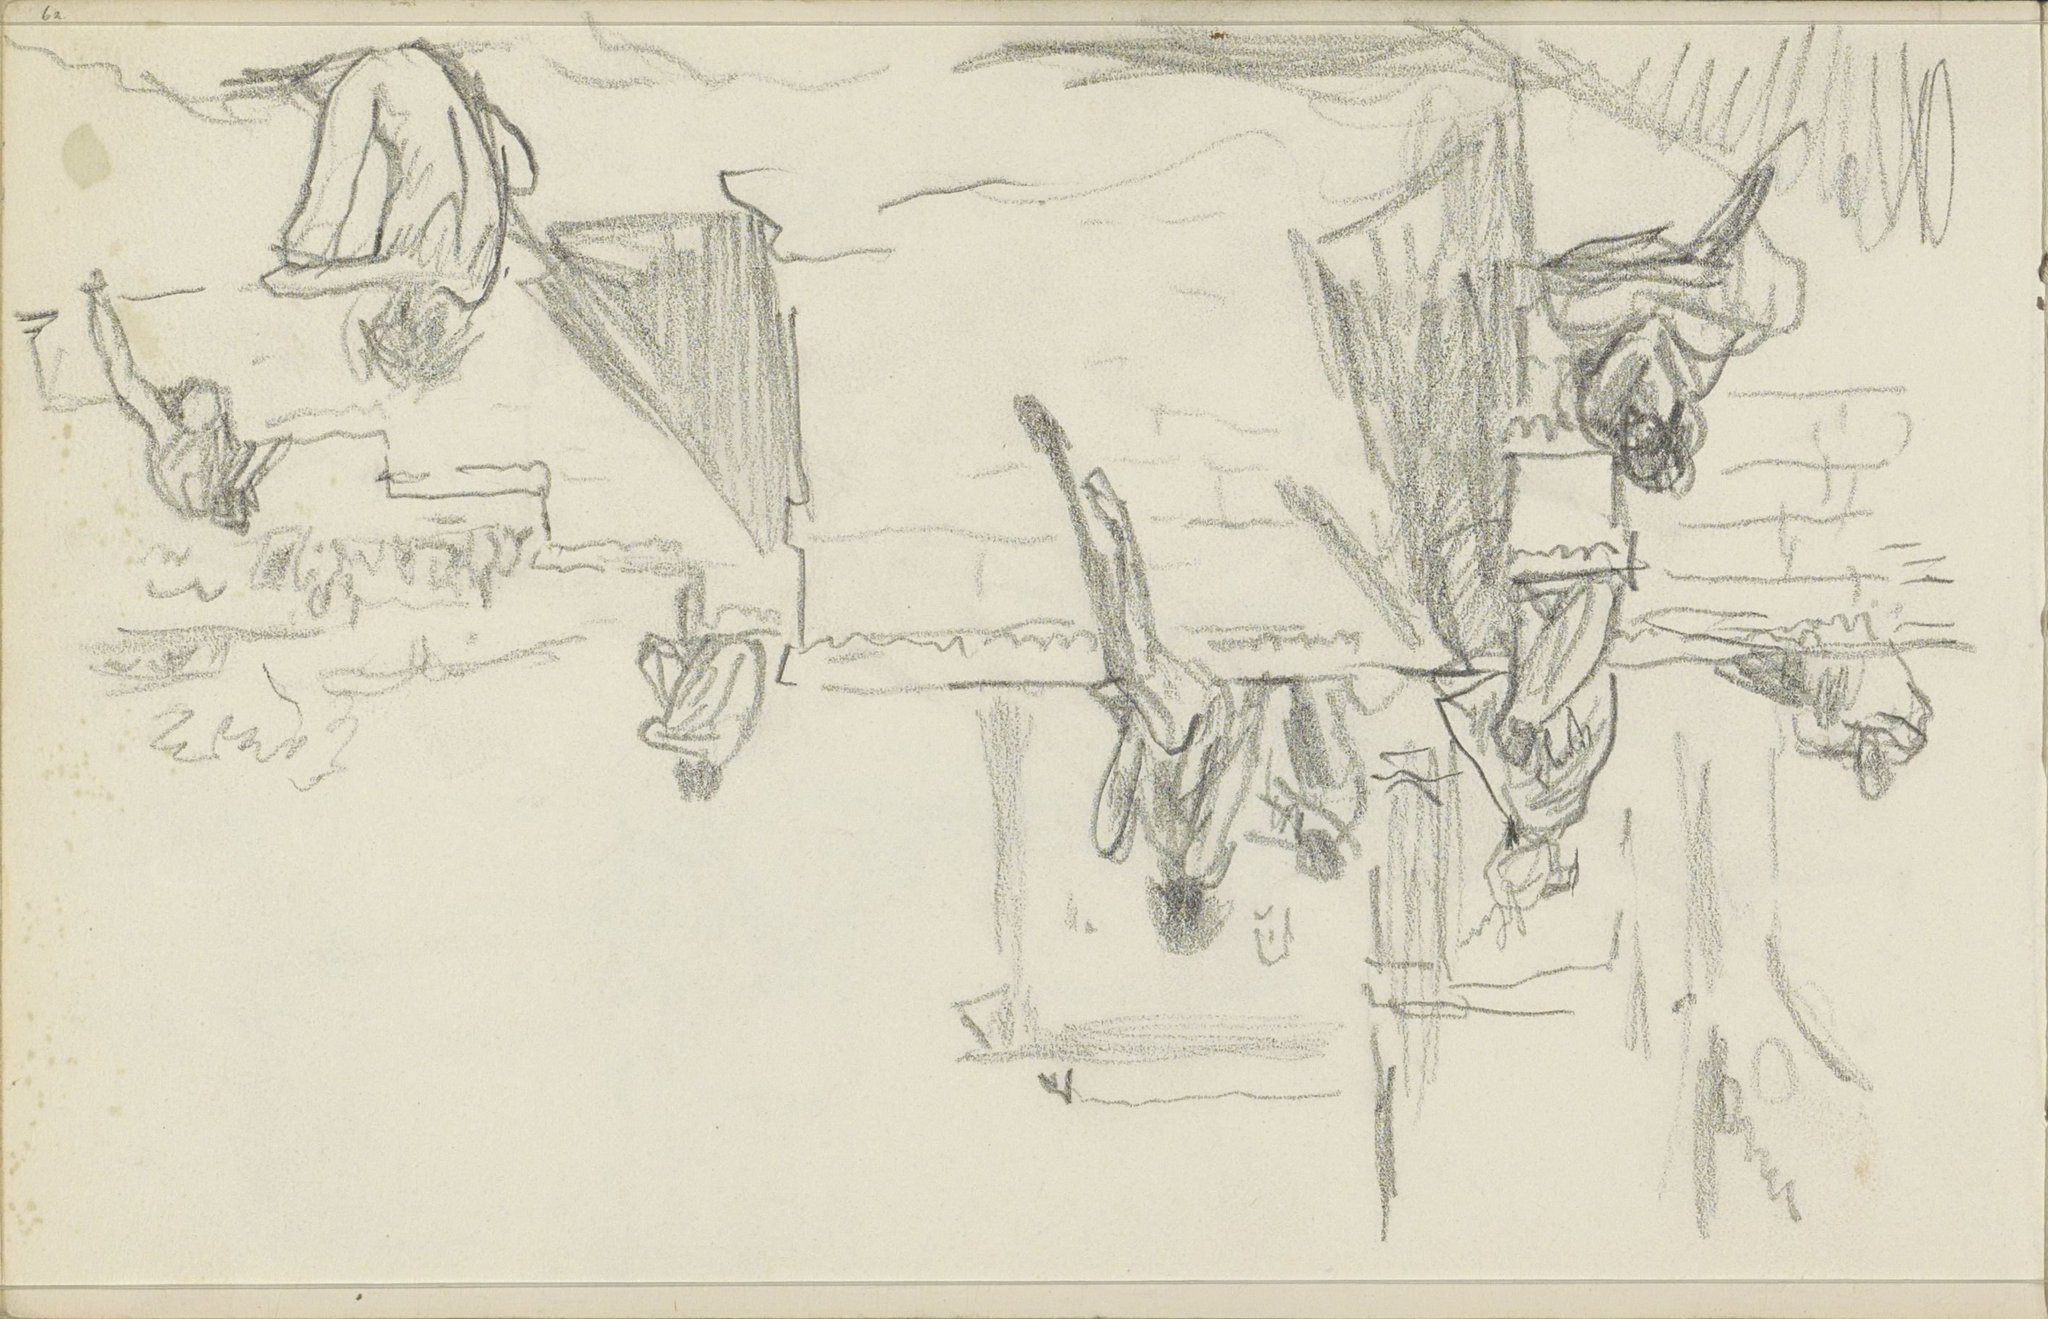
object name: sketchbook leaf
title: Indiërs zittend op een trap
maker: marius bauer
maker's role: draughtsman, print maker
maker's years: 1867-1932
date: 1924-1925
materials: paper, pencil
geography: india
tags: sitting figure, flight of steps, asiatic races and peoples: indians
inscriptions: kleurnotitie, handgeschreven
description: Mogelijk een tempeltrap of een trap die naar de rivier de Ganges leidt. Pagina 62 uit een schetsboek met 48 bladen.